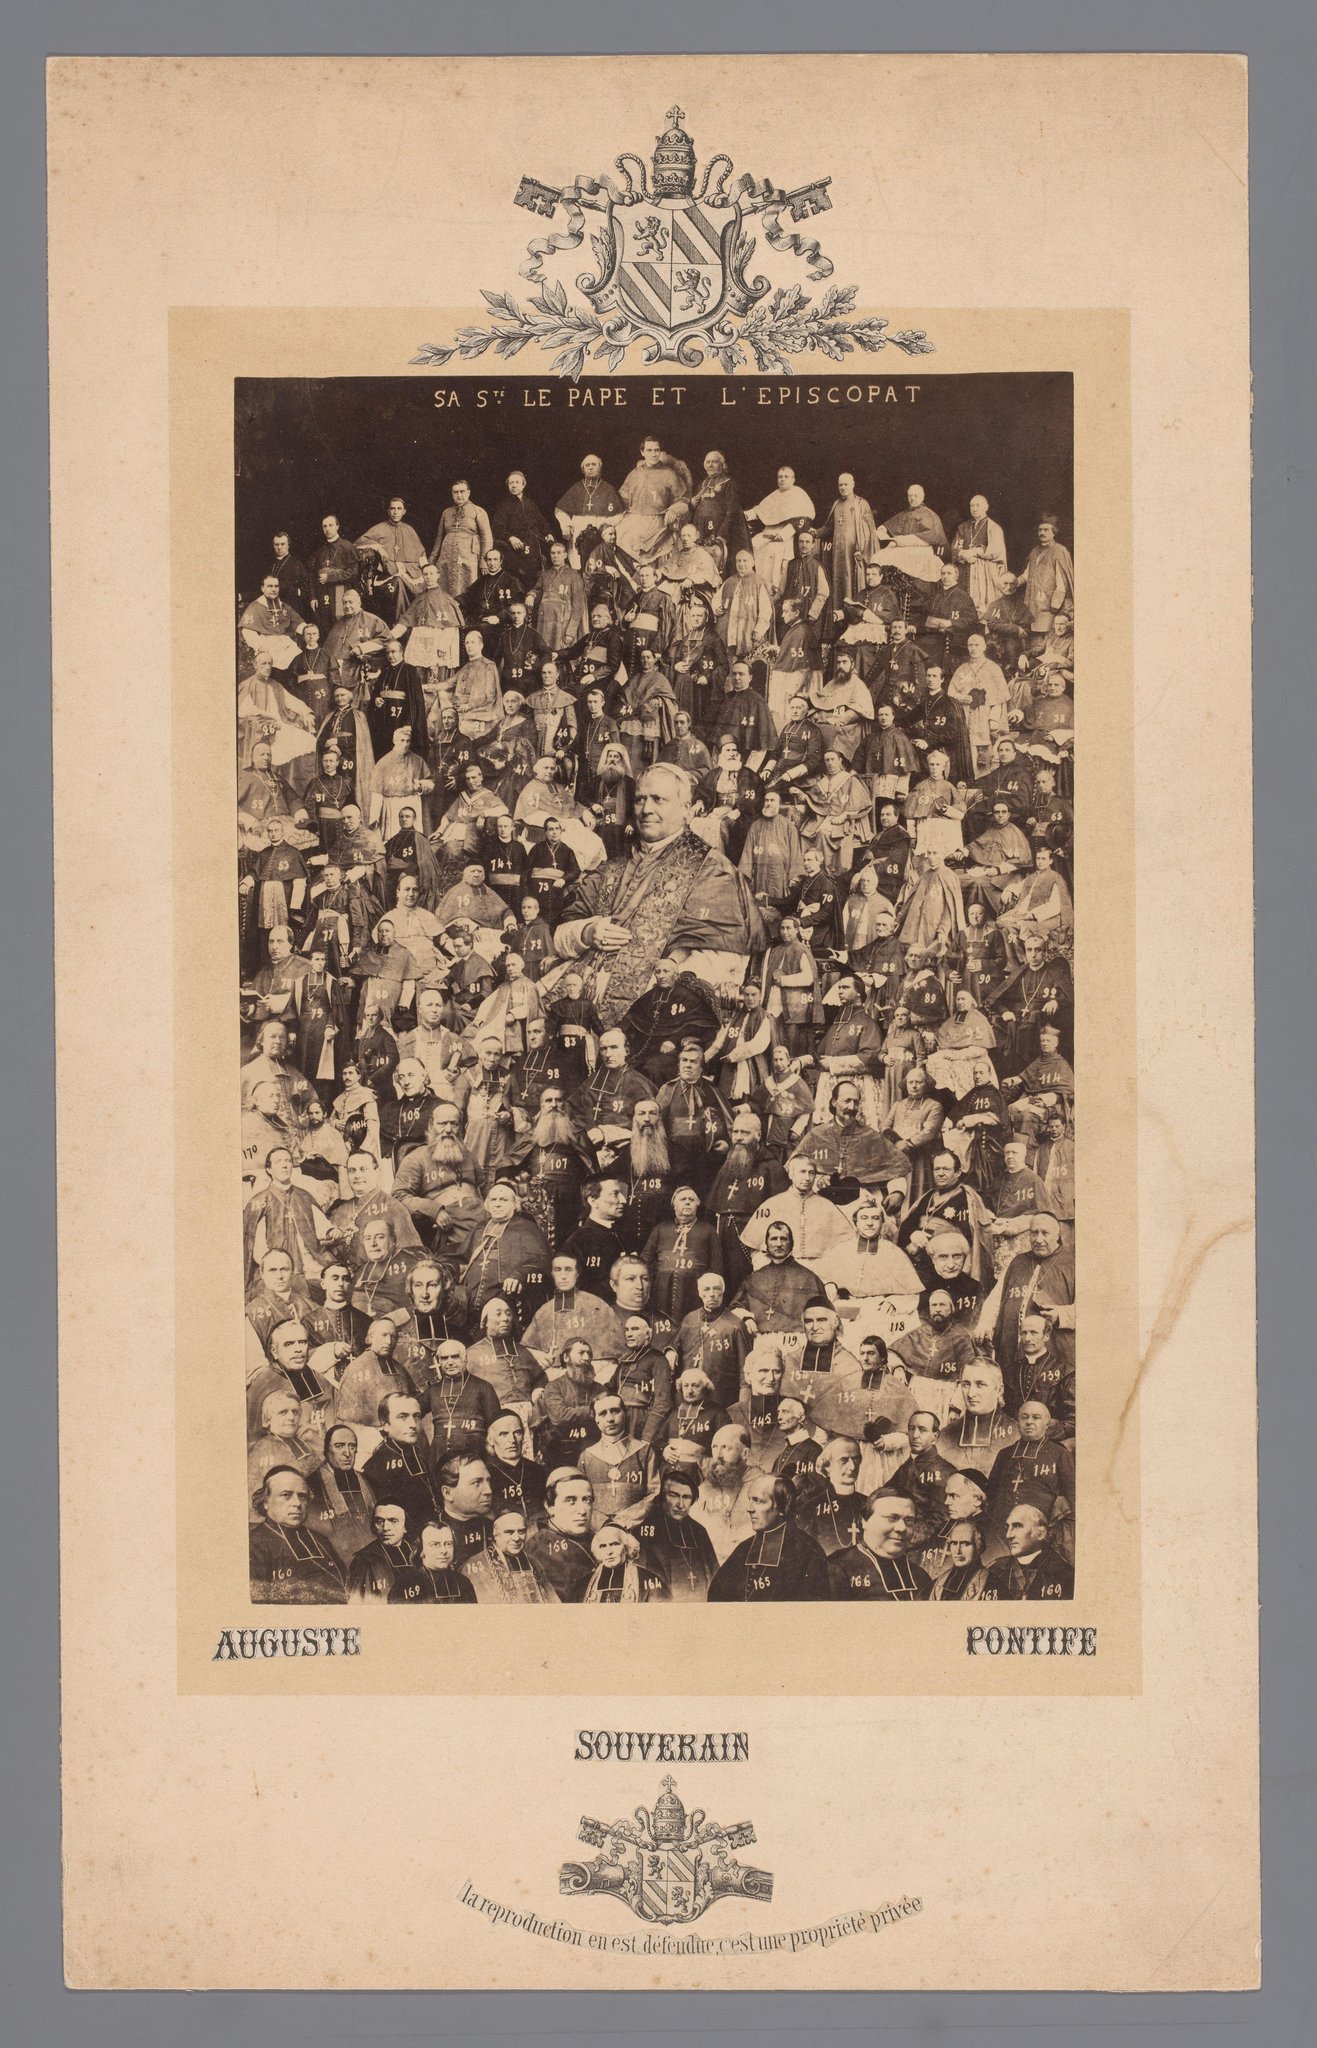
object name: photocollage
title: Sa Ste le pape et l'episcopat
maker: mirrehelle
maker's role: fotograaf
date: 1851-1900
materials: cardboard, paper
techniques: albumen print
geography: brussels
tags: pope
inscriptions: address: ‘4. Chaussée d'Etterbeek,/ BRUXELLES.’, inscription: ‘AUGUSTE PONTIFE/ SOUVERAIN/ la reproduction en est défendre, c'est une proprieté privée’, number